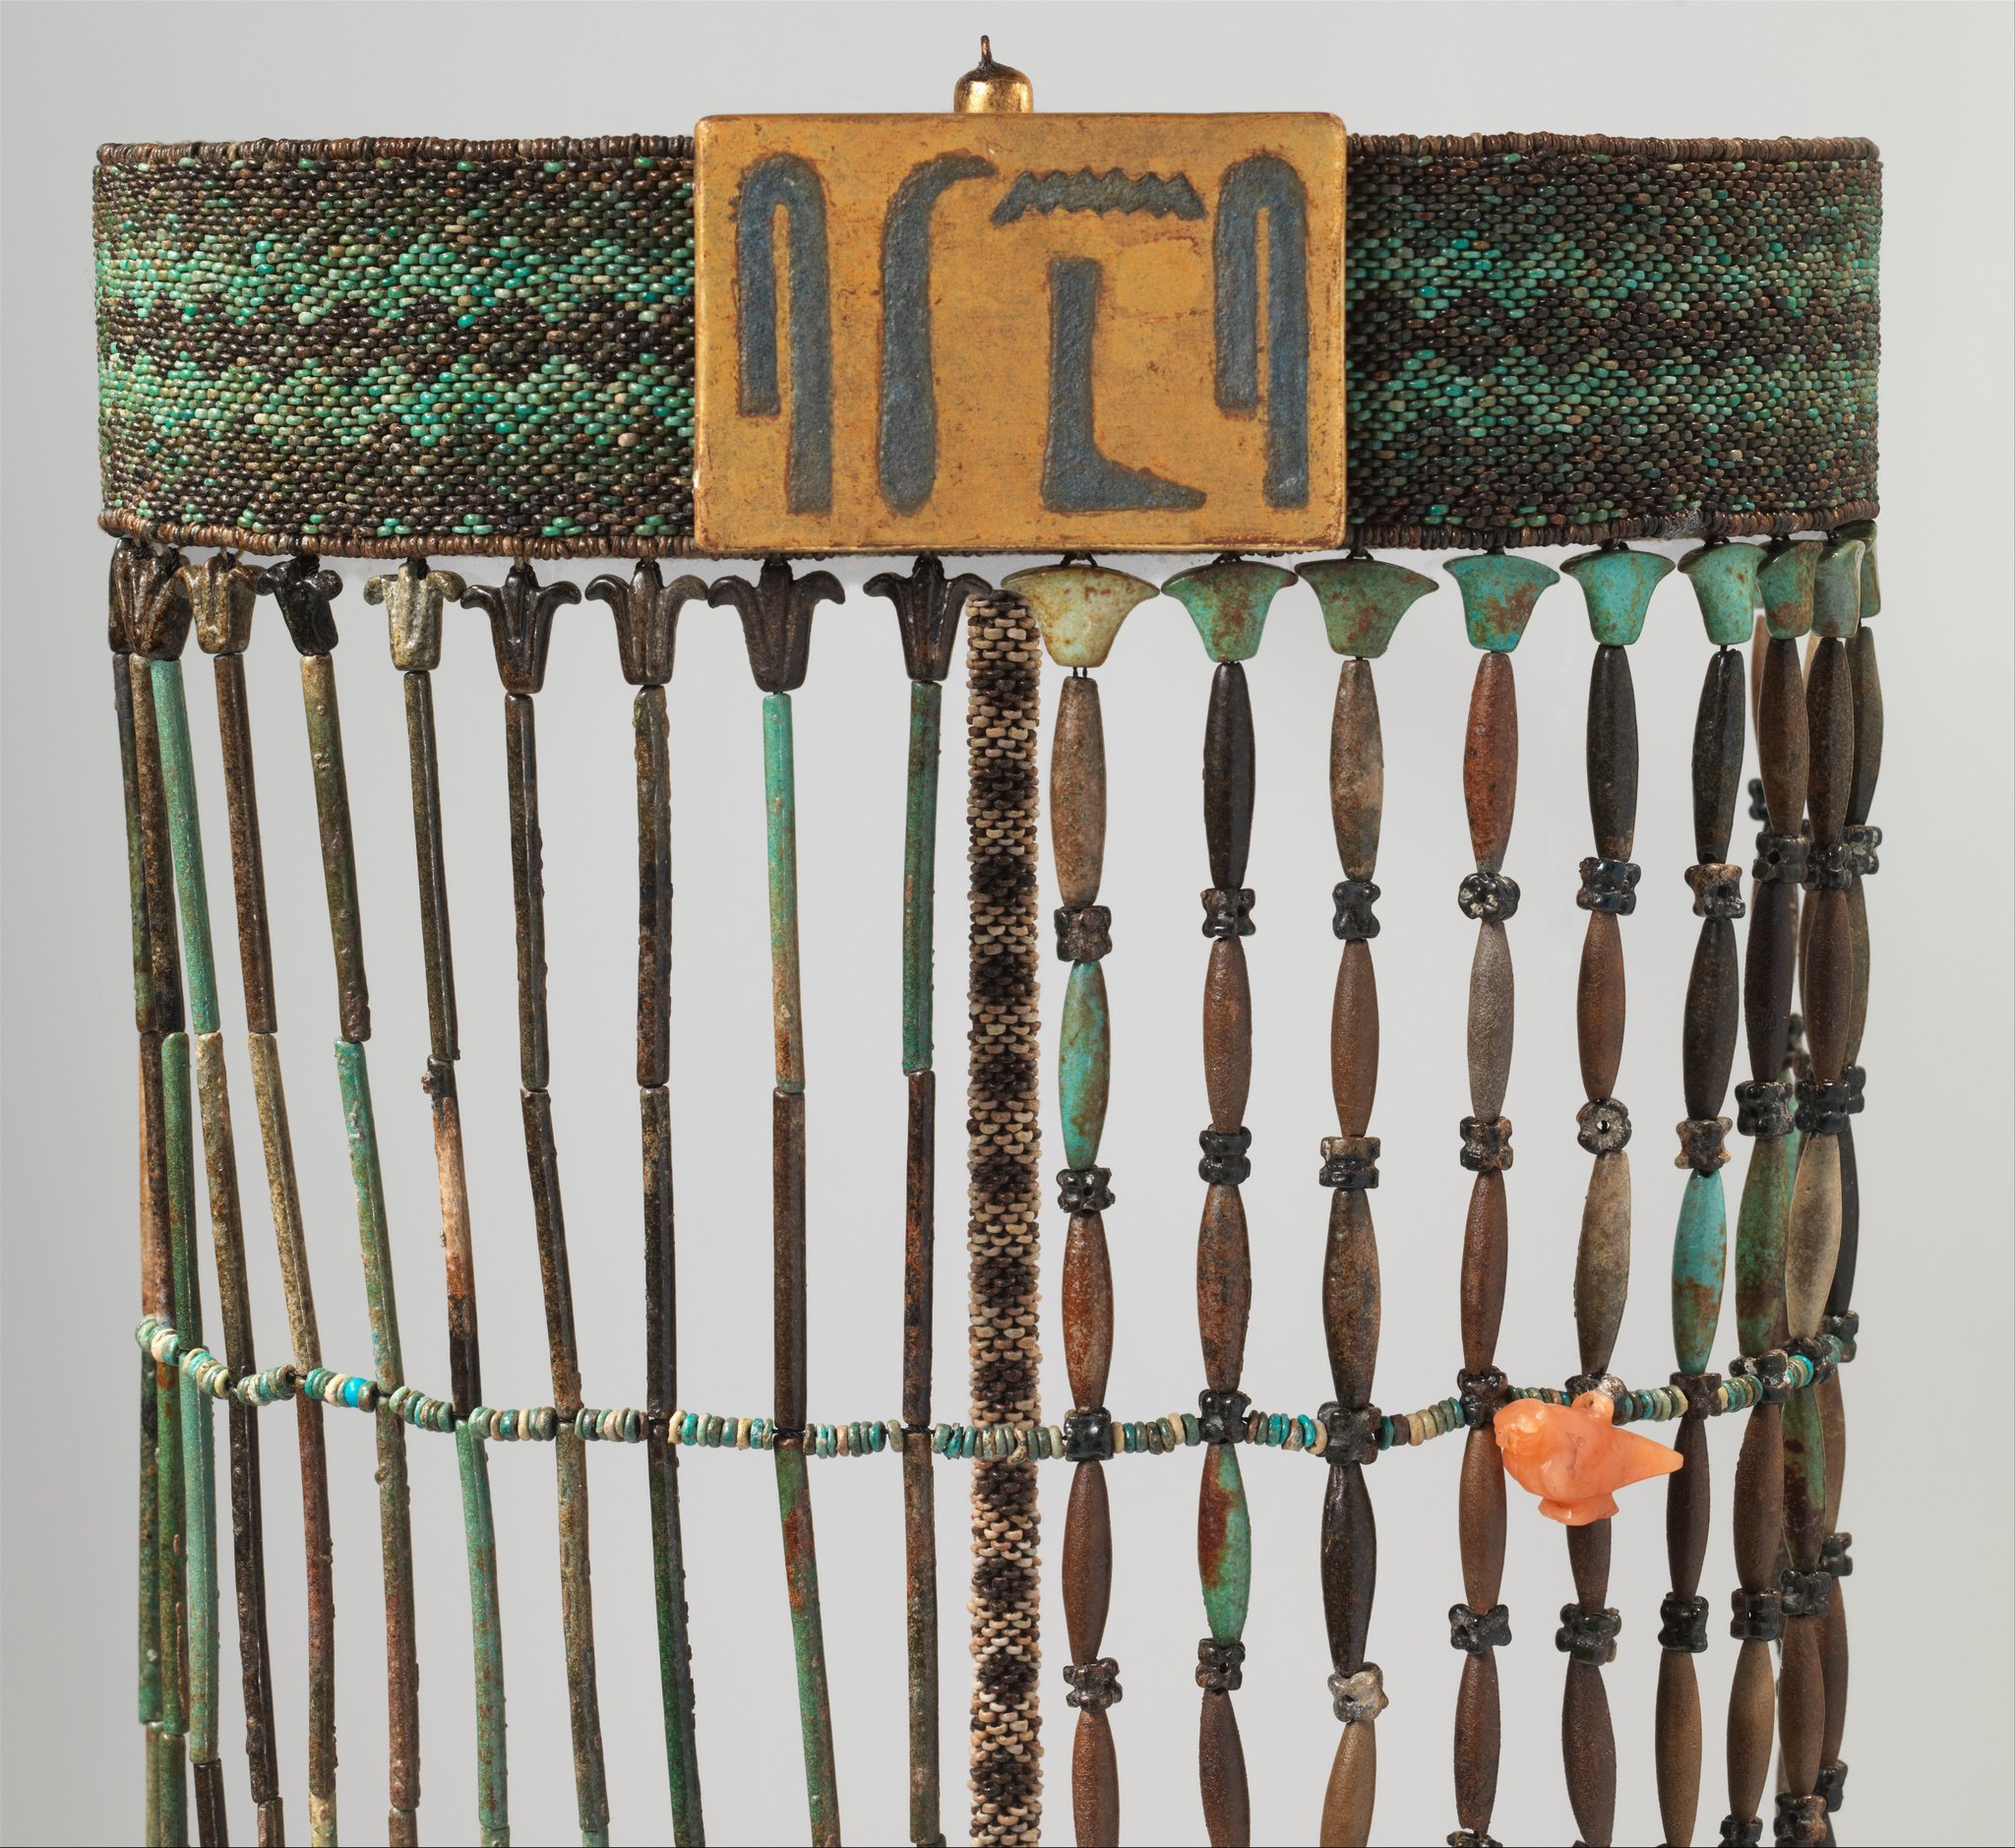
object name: apron, beadwork, senebtisi, buckle replica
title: Buckle (replica) for beadwork apron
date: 1850-1775 BCE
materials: paint, wood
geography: egypt